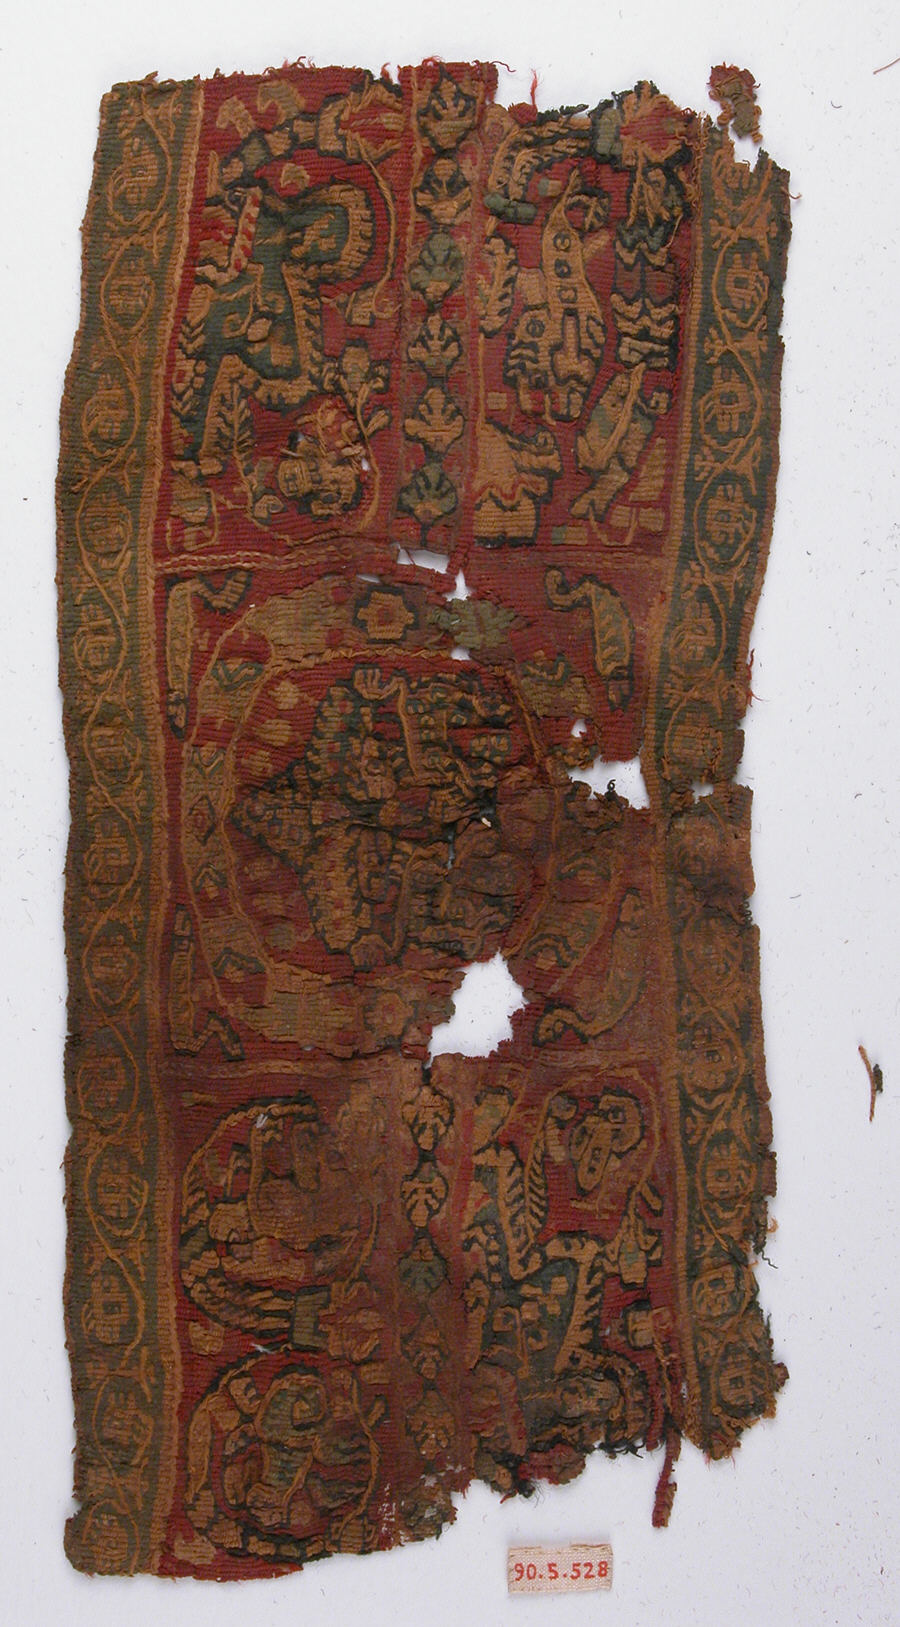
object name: textile fragment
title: Fragment of a Sleeve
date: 601-800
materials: linen, wool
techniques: weave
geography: egypt